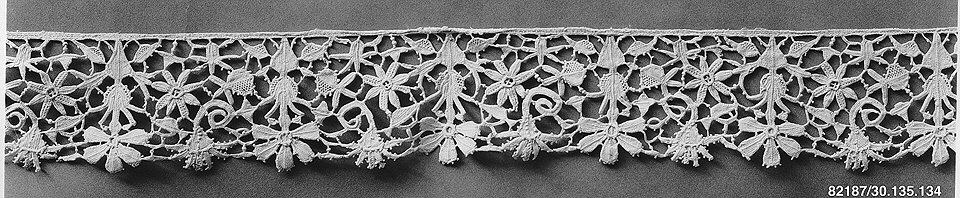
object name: border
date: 1501-1700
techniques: lace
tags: flowers